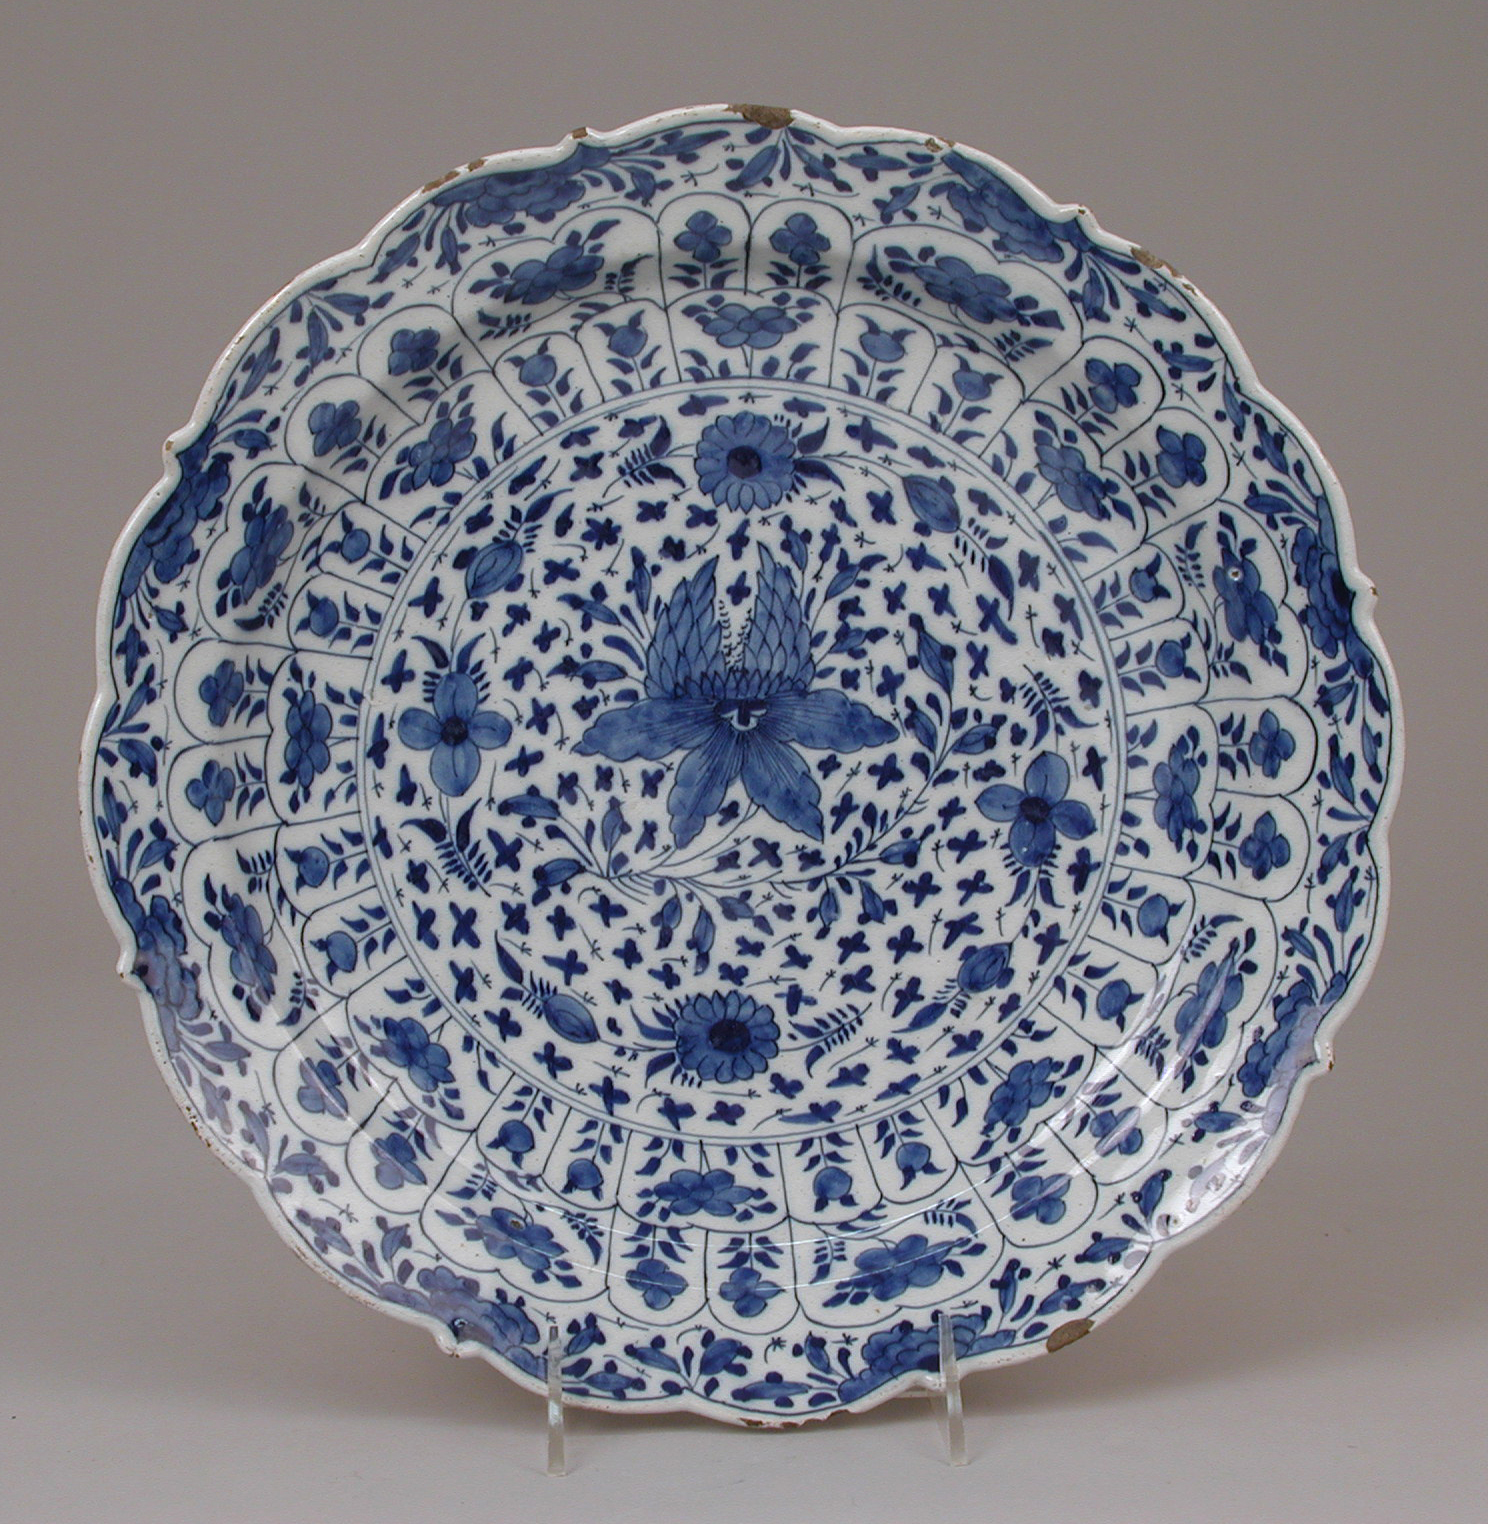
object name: dish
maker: de porceleyne bijl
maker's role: factory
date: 1750-1775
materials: earthenware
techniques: glazing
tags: flowers